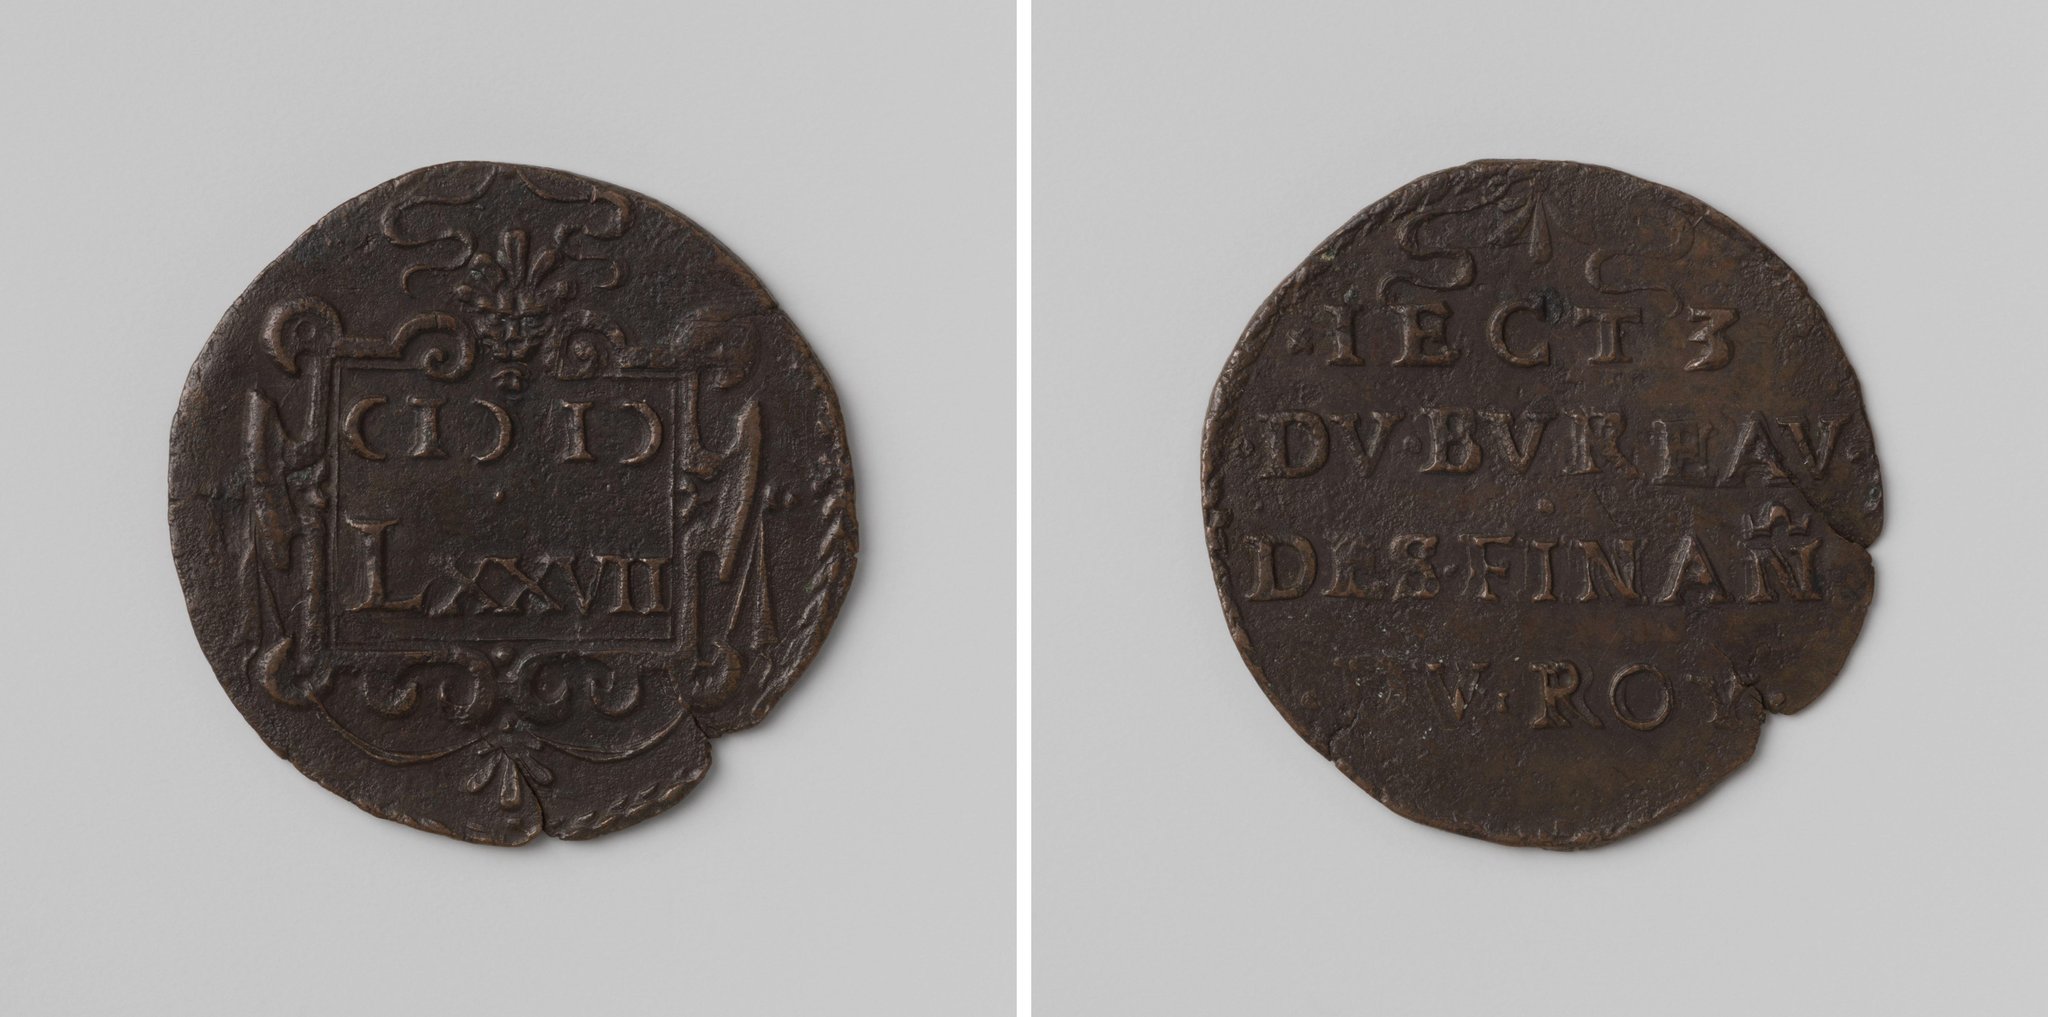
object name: jeton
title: Rekenpenning van de raad van Financiën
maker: Anonymous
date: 1577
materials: copper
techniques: striking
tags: philip ii of spain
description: Koperen penning. Voorzijde: opschrift binnen lauwerkrans. Keerzijde: jaartal binnen versierd cartouche